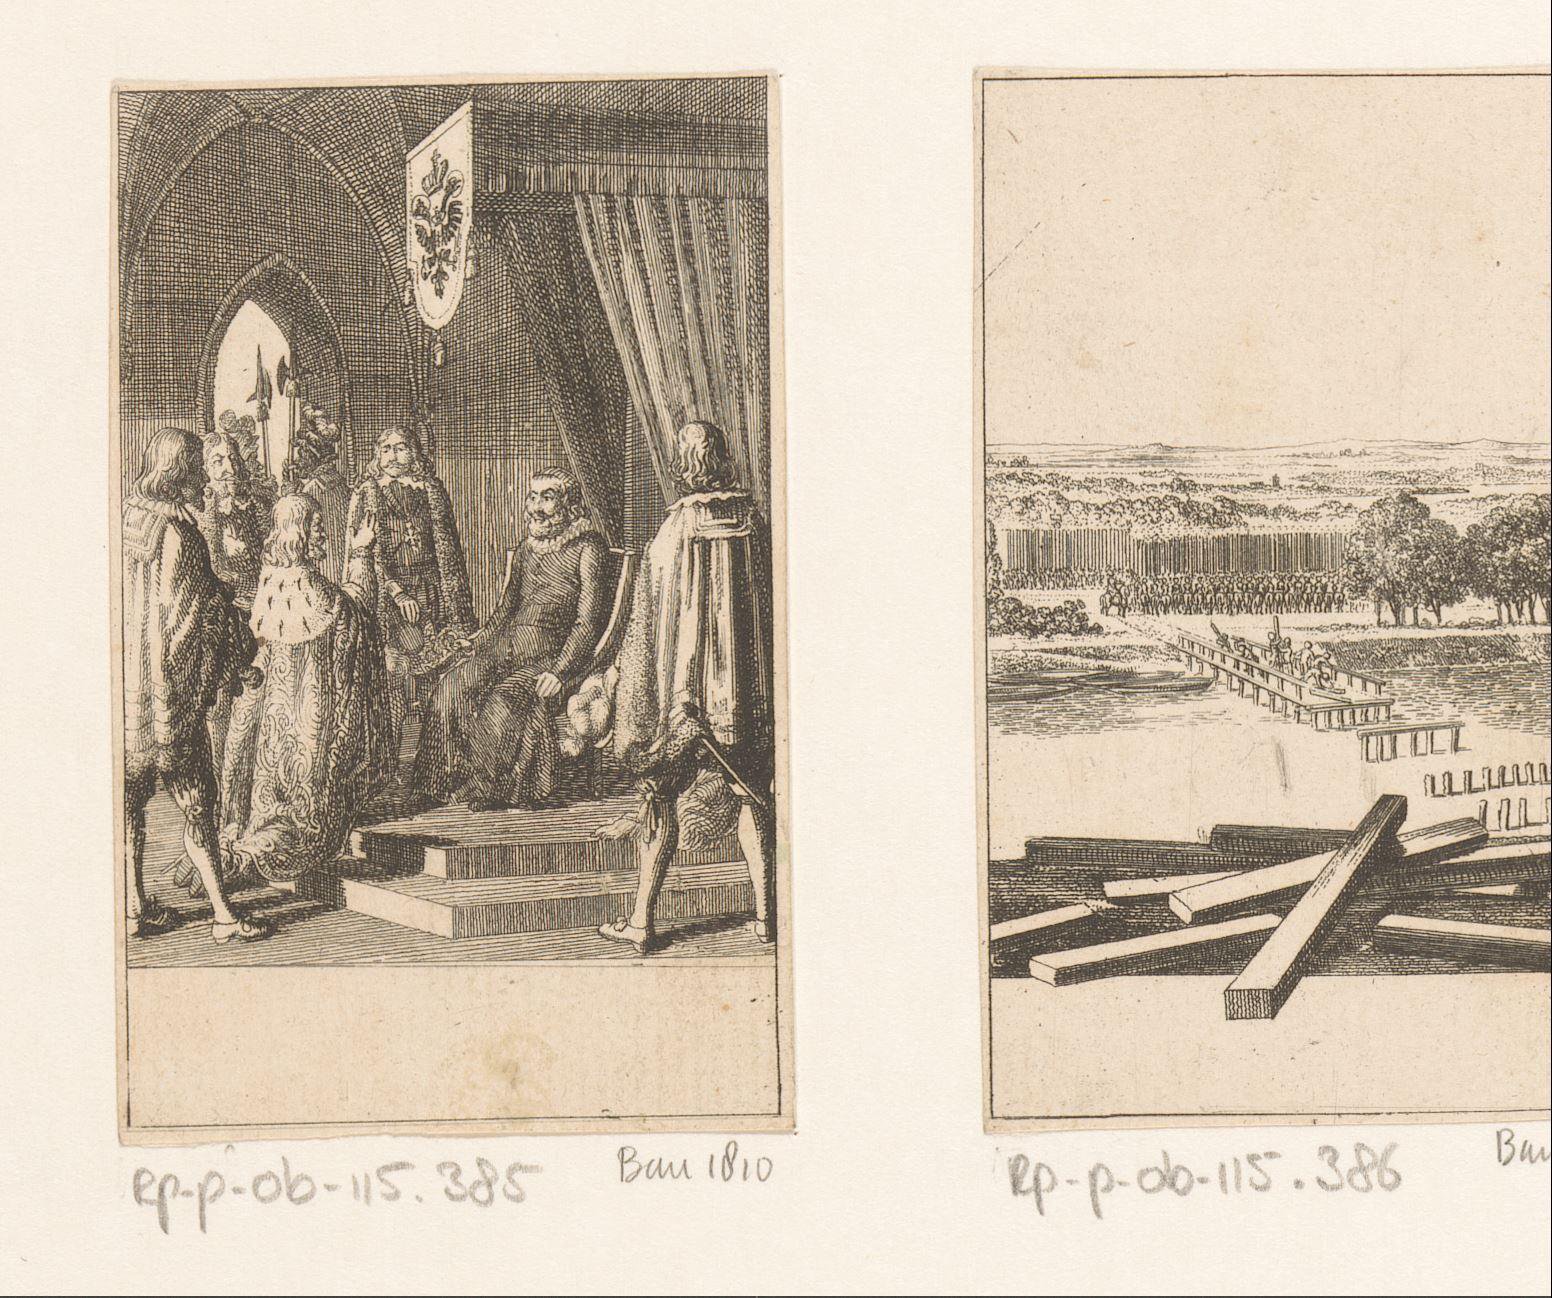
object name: print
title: Ottokar II van Bohemen knielt voor Rudolf I van Habsburg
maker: daniel nikolaus chodowiecki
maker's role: draughtsman, print maker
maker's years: 1726-1801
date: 1795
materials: paper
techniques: etching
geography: berlin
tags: double-headed eagle, history, ruler, sovereign, kneeling figure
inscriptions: collector's mark: Lugt 2228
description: Latere staat gebruikt voor: Königl. Grossbritanischer Historischer Genealogischer Calender für 1796 (...). Lauenburg en Franfurt am Main: Johann Georg Berenberg en Jaegerschen Buchhandlung, [1795].